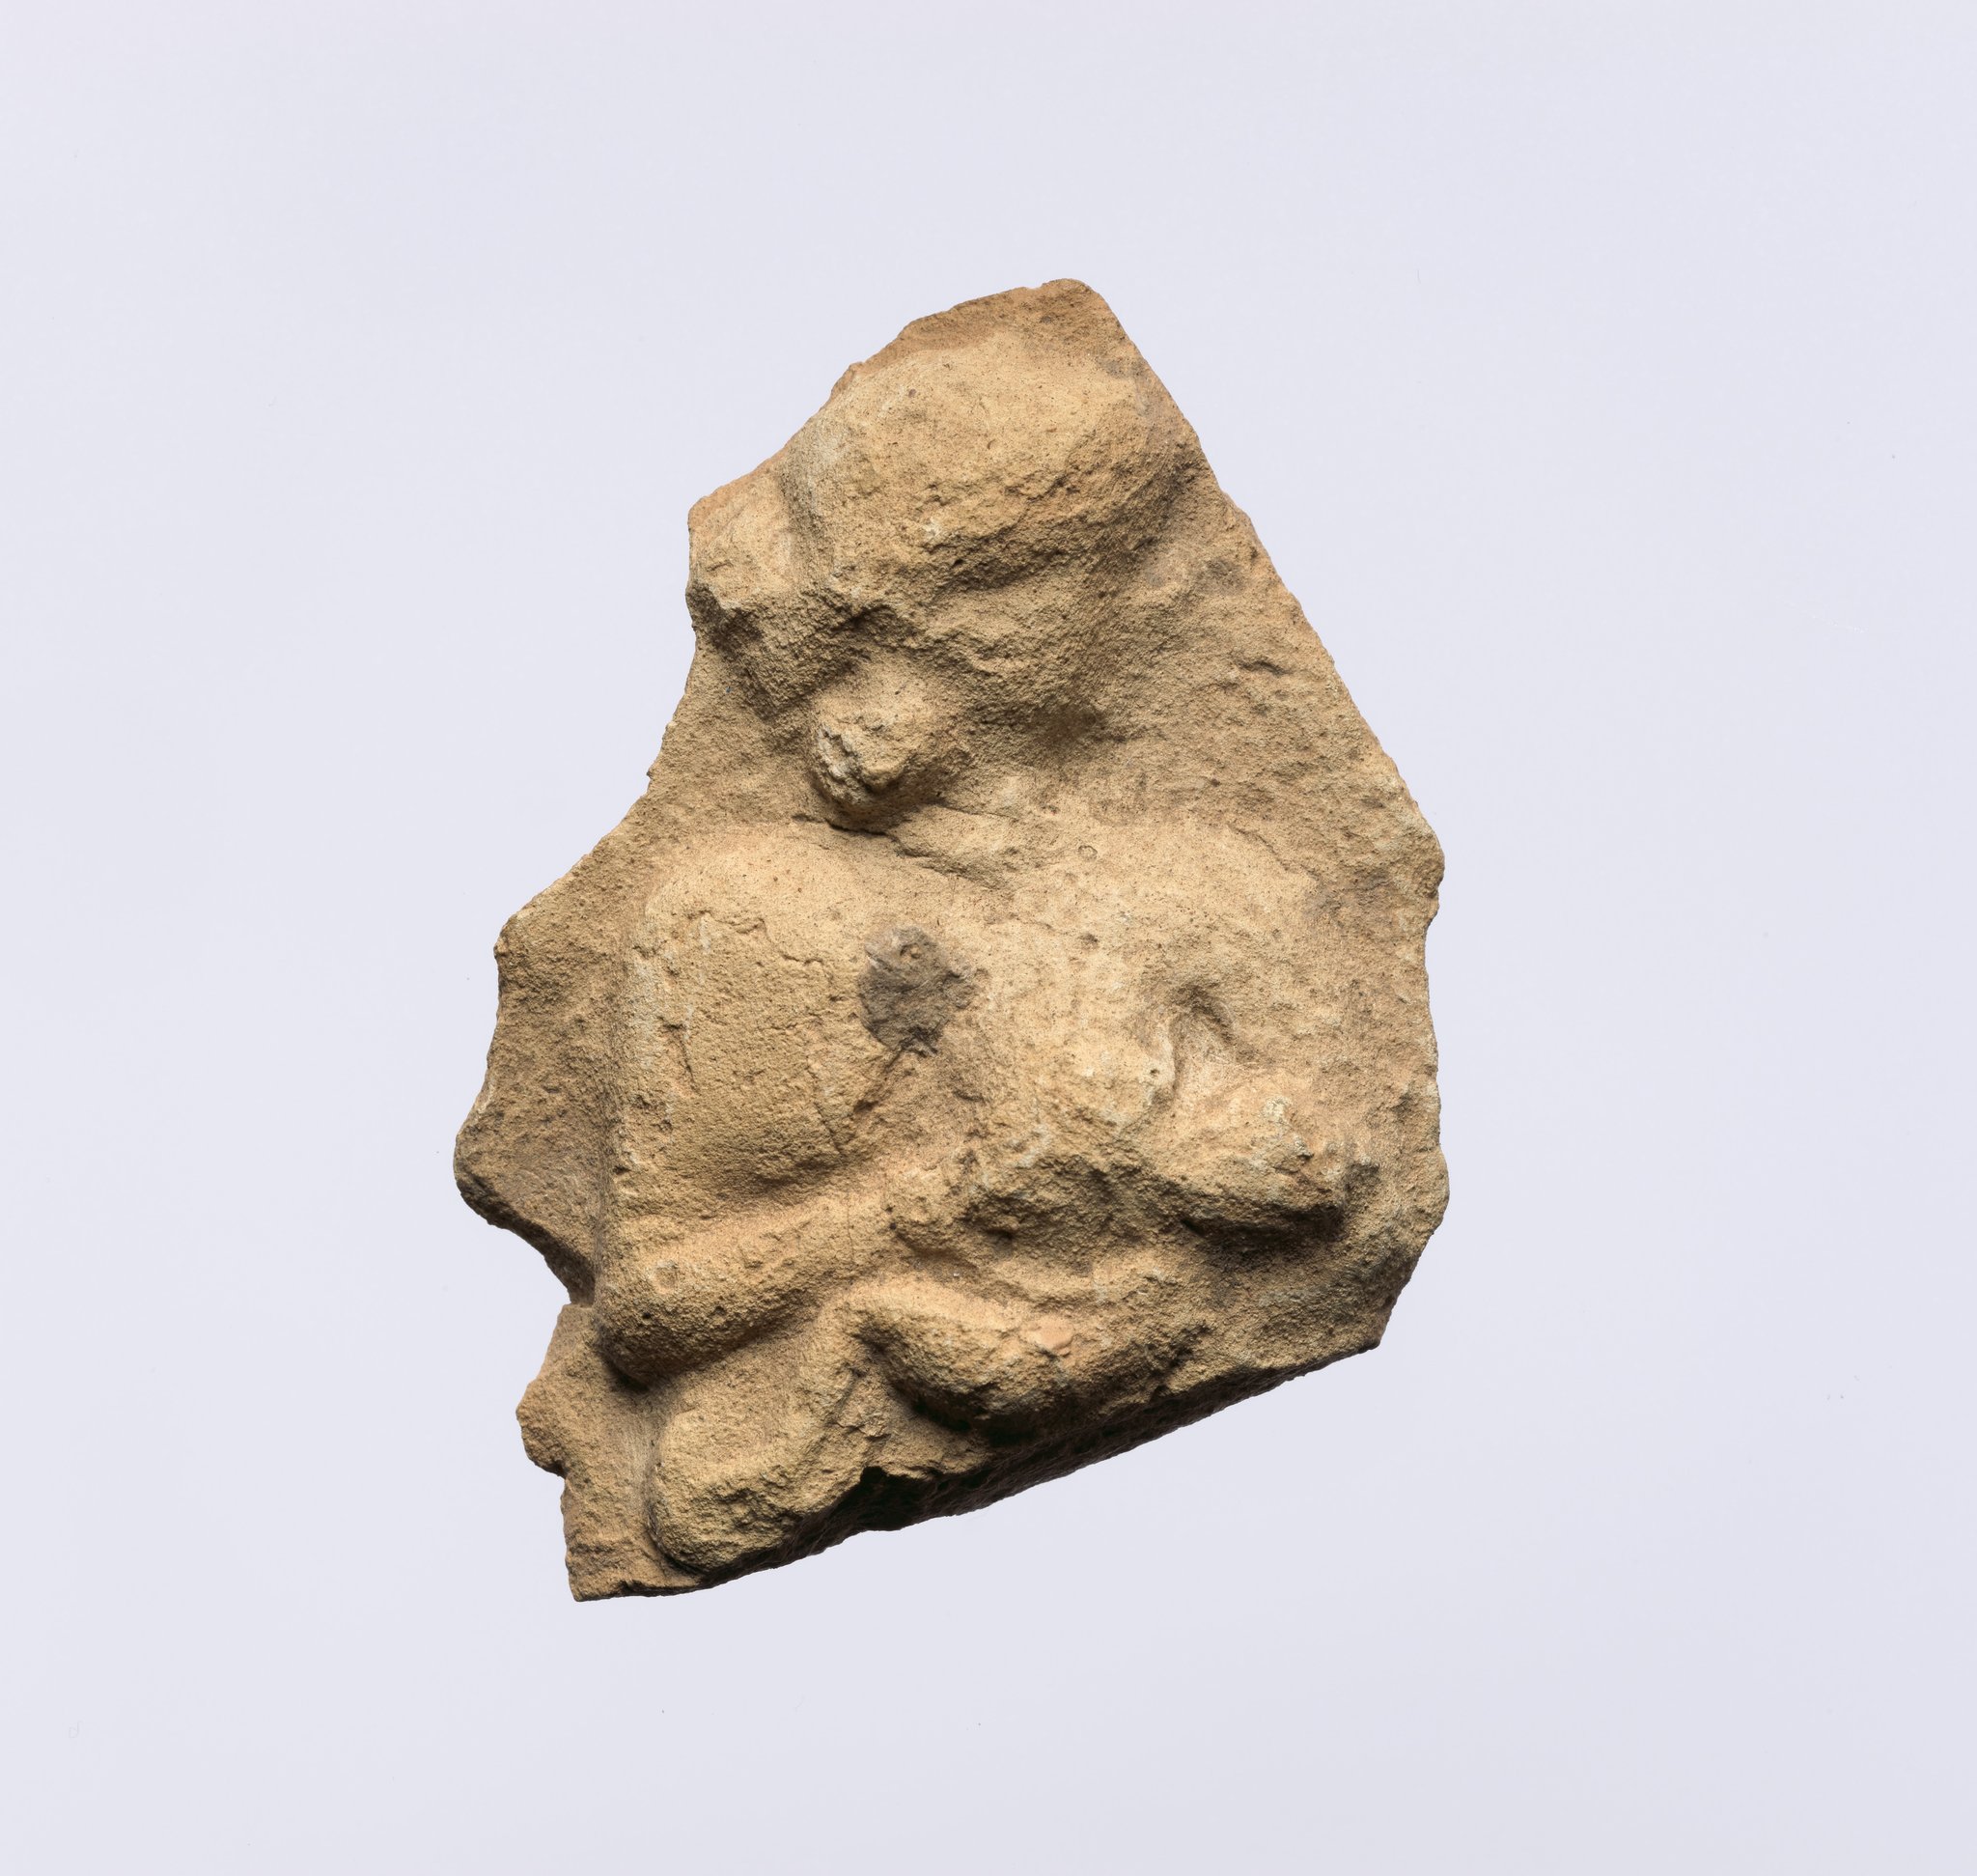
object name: relief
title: Plaque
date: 2000-1600 BCE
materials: ceramic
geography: mesopotamia